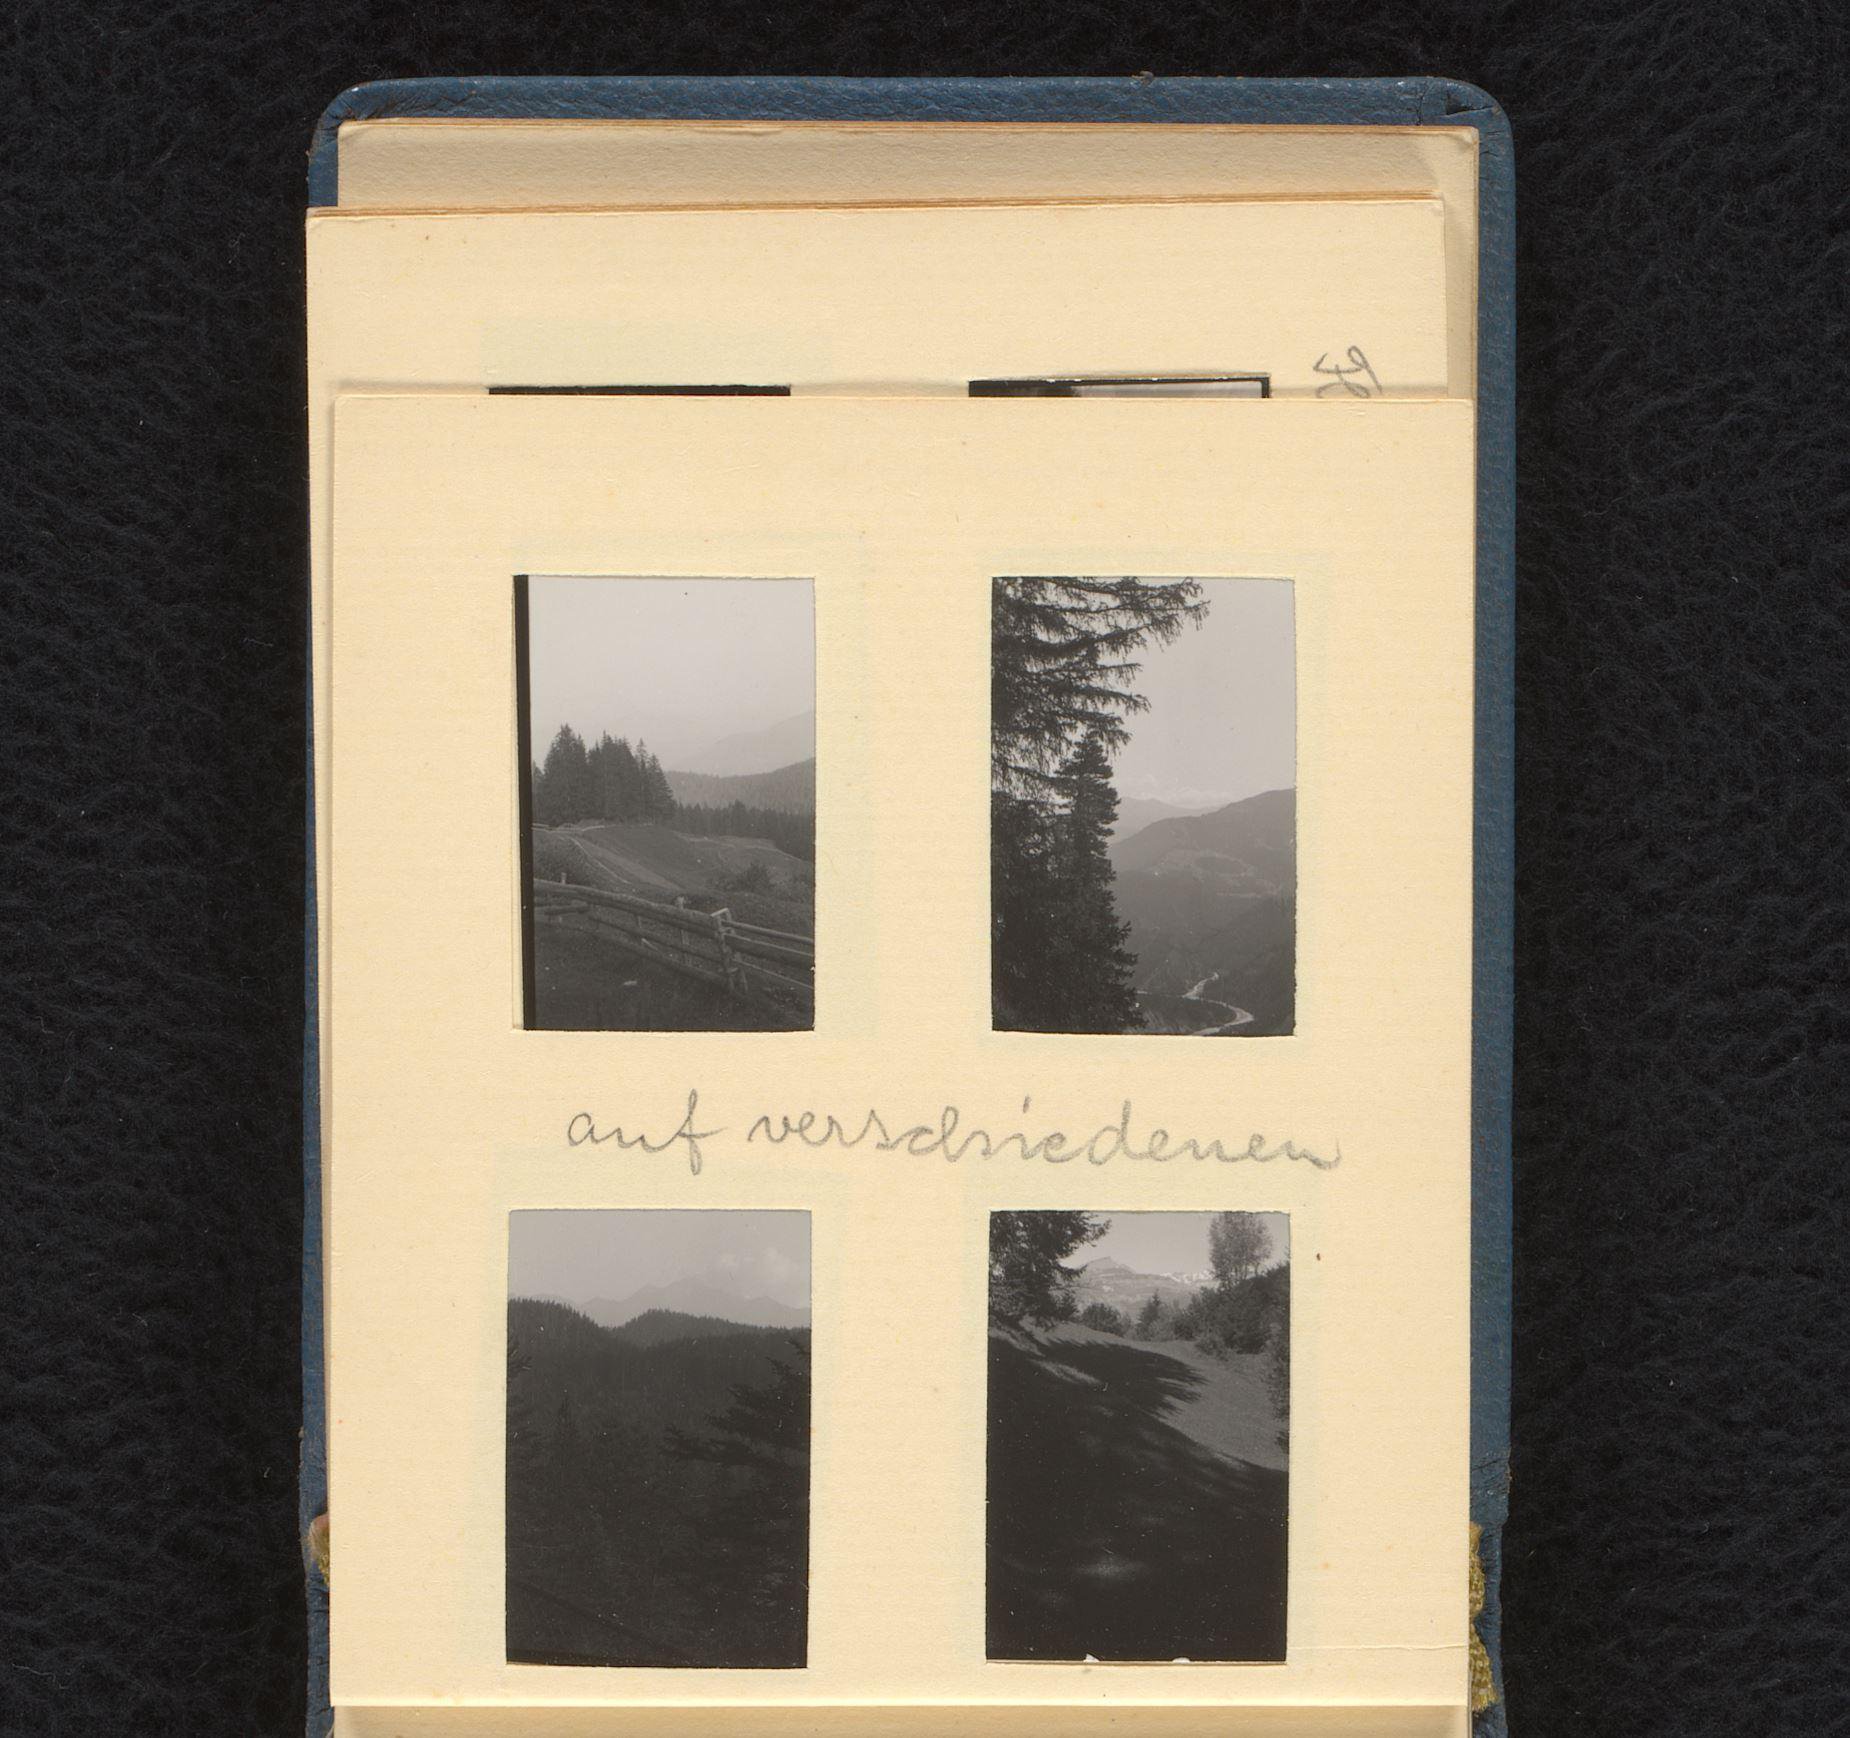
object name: photograph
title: Wandelroutes in de Zwitserse plaatsen Flims-Dorf en Flims-Waldhaus, tijdens een vakantie van de familie Wachenheimer, augustus 1936, Zwitserland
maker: else wachenheimer-moos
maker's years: 1895-1944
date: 1908-1936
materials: paper, photographic support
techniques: gelatin silver print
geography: switzerland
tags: the family travelling, on holiday, mountain-range, snow peaks, switzerland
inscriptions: inscription: ‘auf verschiedenen’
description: Albumblad bevat vier foto's. Zonder personen gerelateerd aan de familie Wachenheimer. Uit klein formaat fotoalbum, blauw lederen omslag met drukknopsluiting. Met foto's in klein formaat.